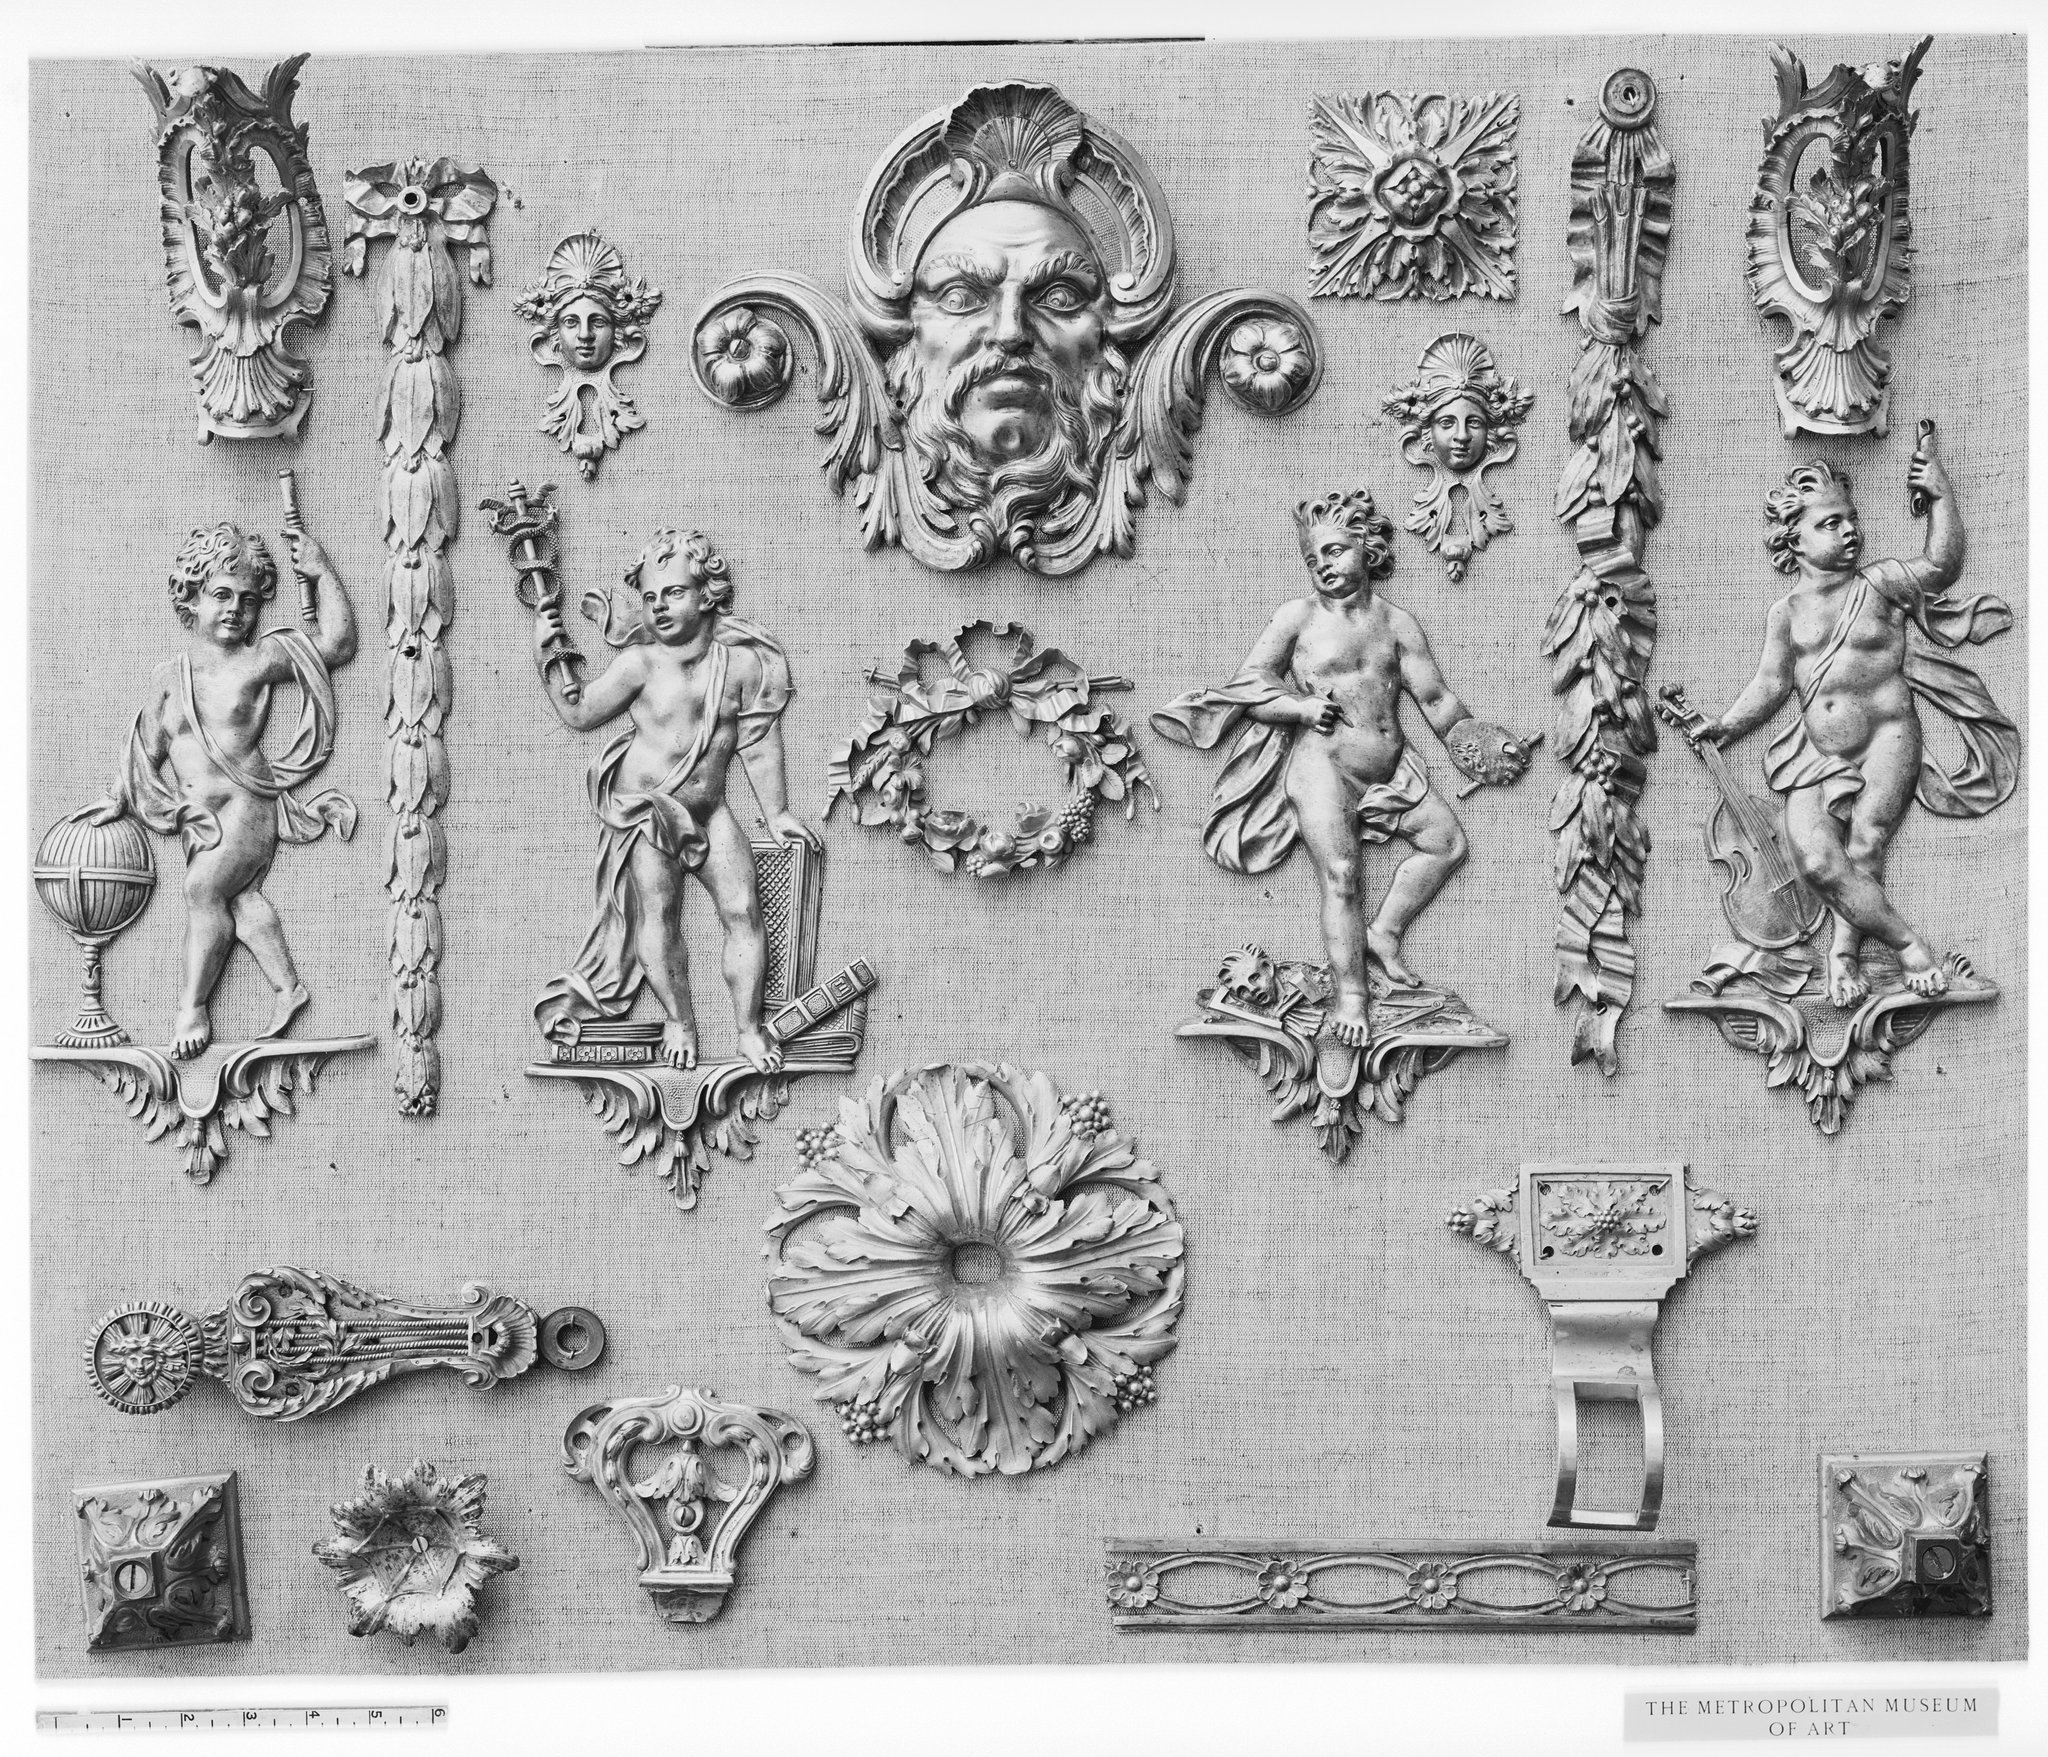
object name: foot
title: Pair of feet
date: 1701-1800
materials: gilt bronze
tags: faces,heads,male nudes,flowers